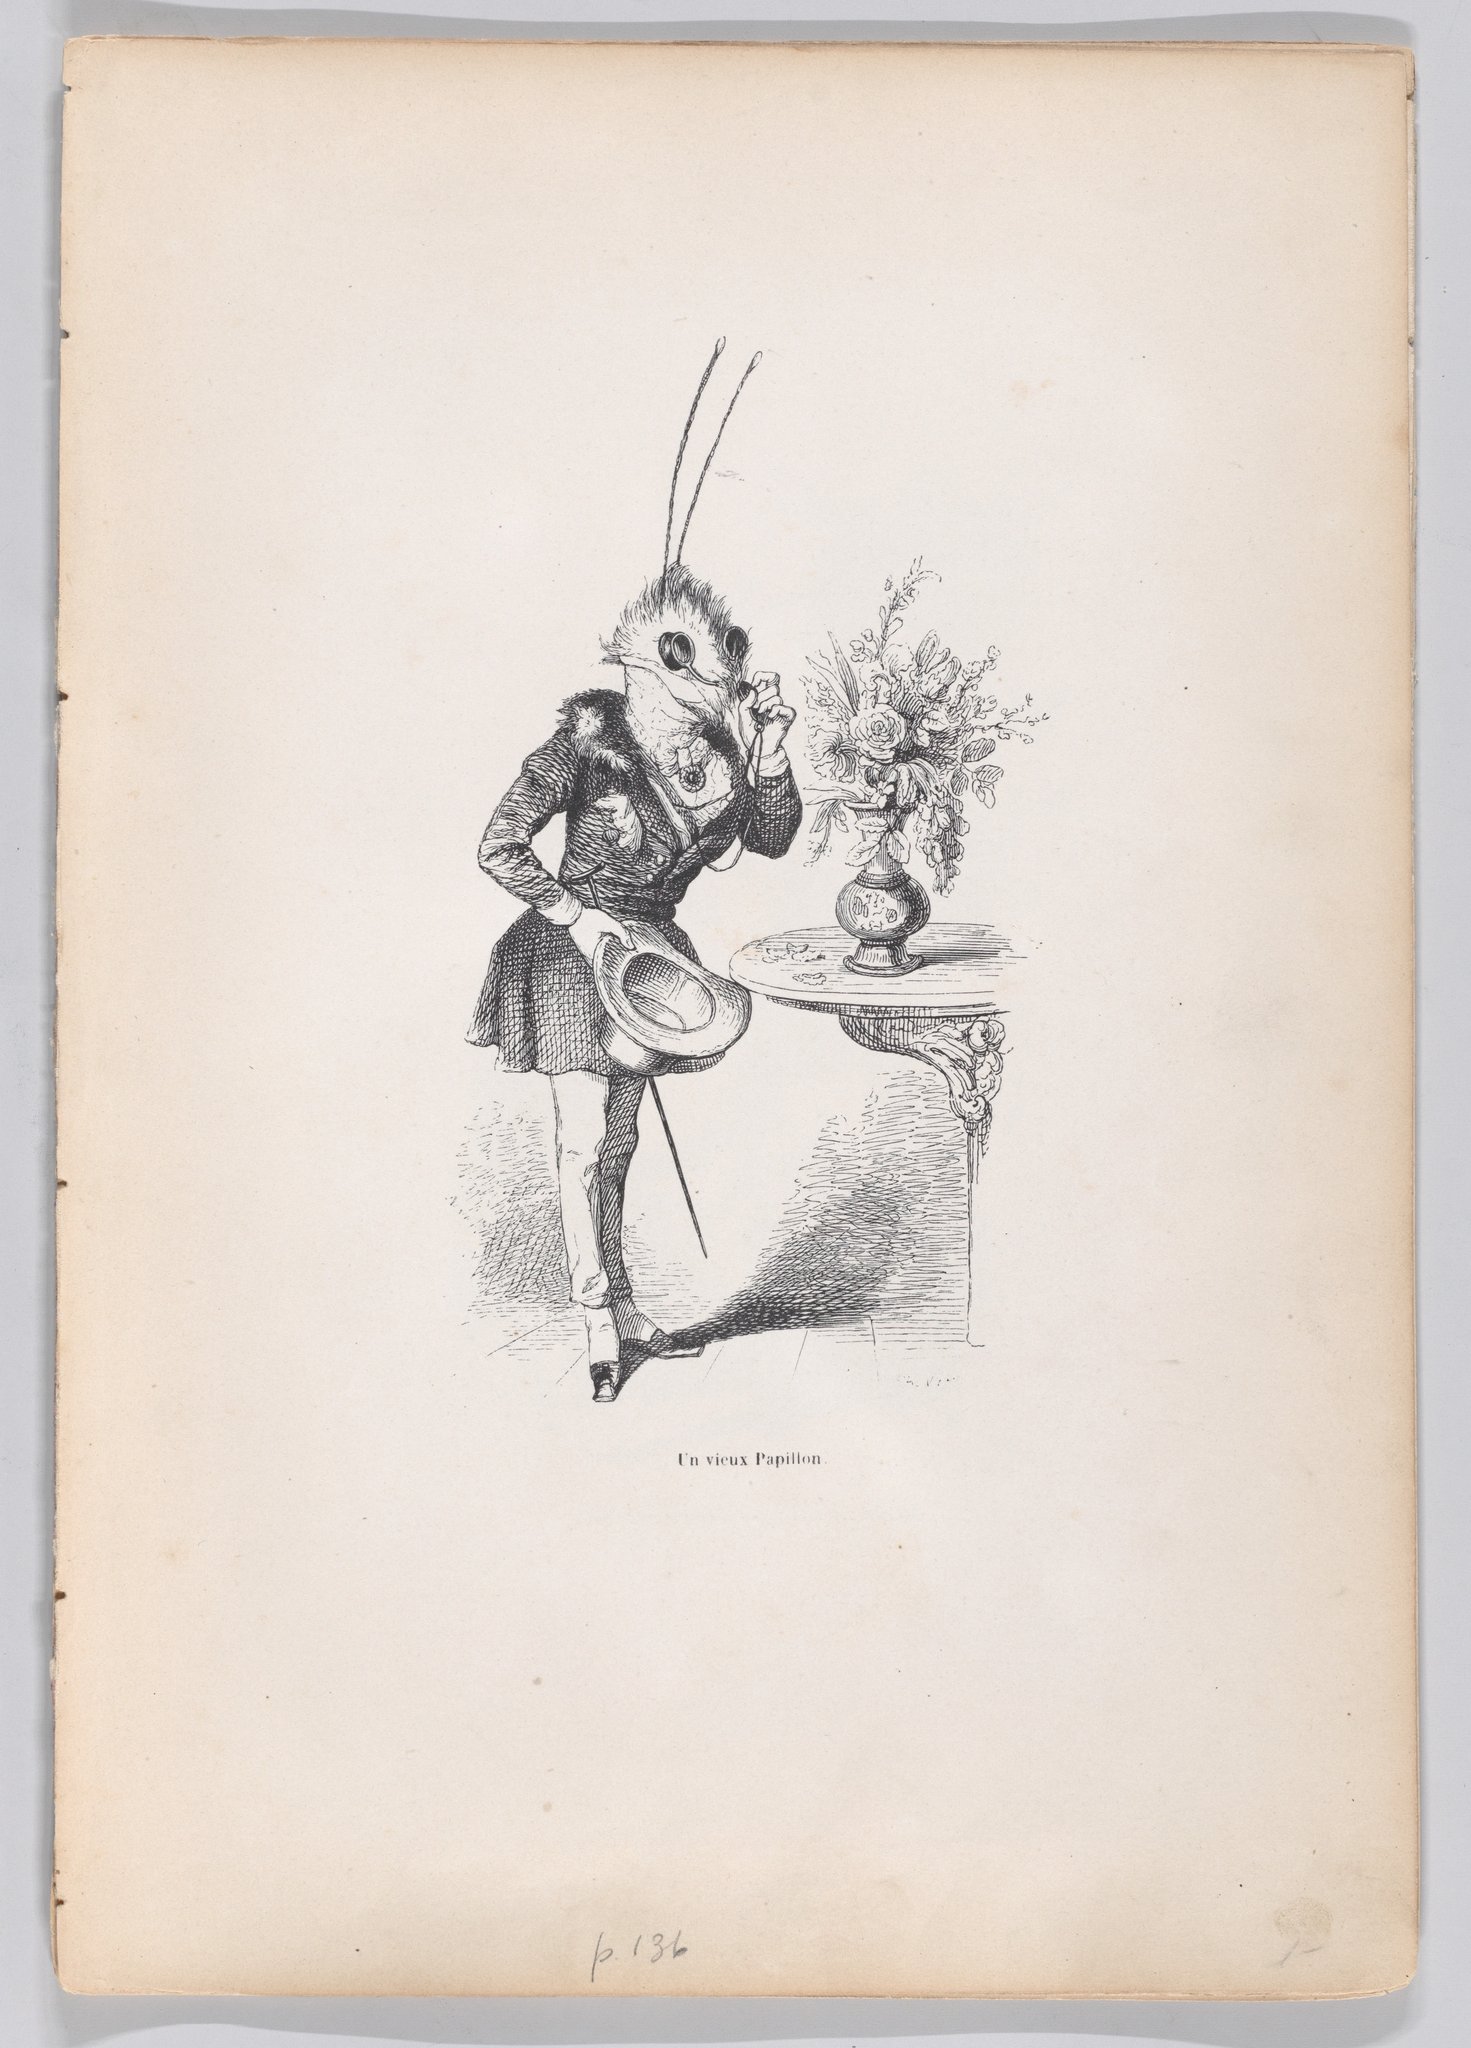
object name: print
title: An Old Butterfly, from "Scenes from the Private and Public Life of Animals"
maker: j. j. grandville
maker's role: illustrator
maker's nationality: french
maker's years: 1803-1847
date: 1837-1847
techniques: engraving